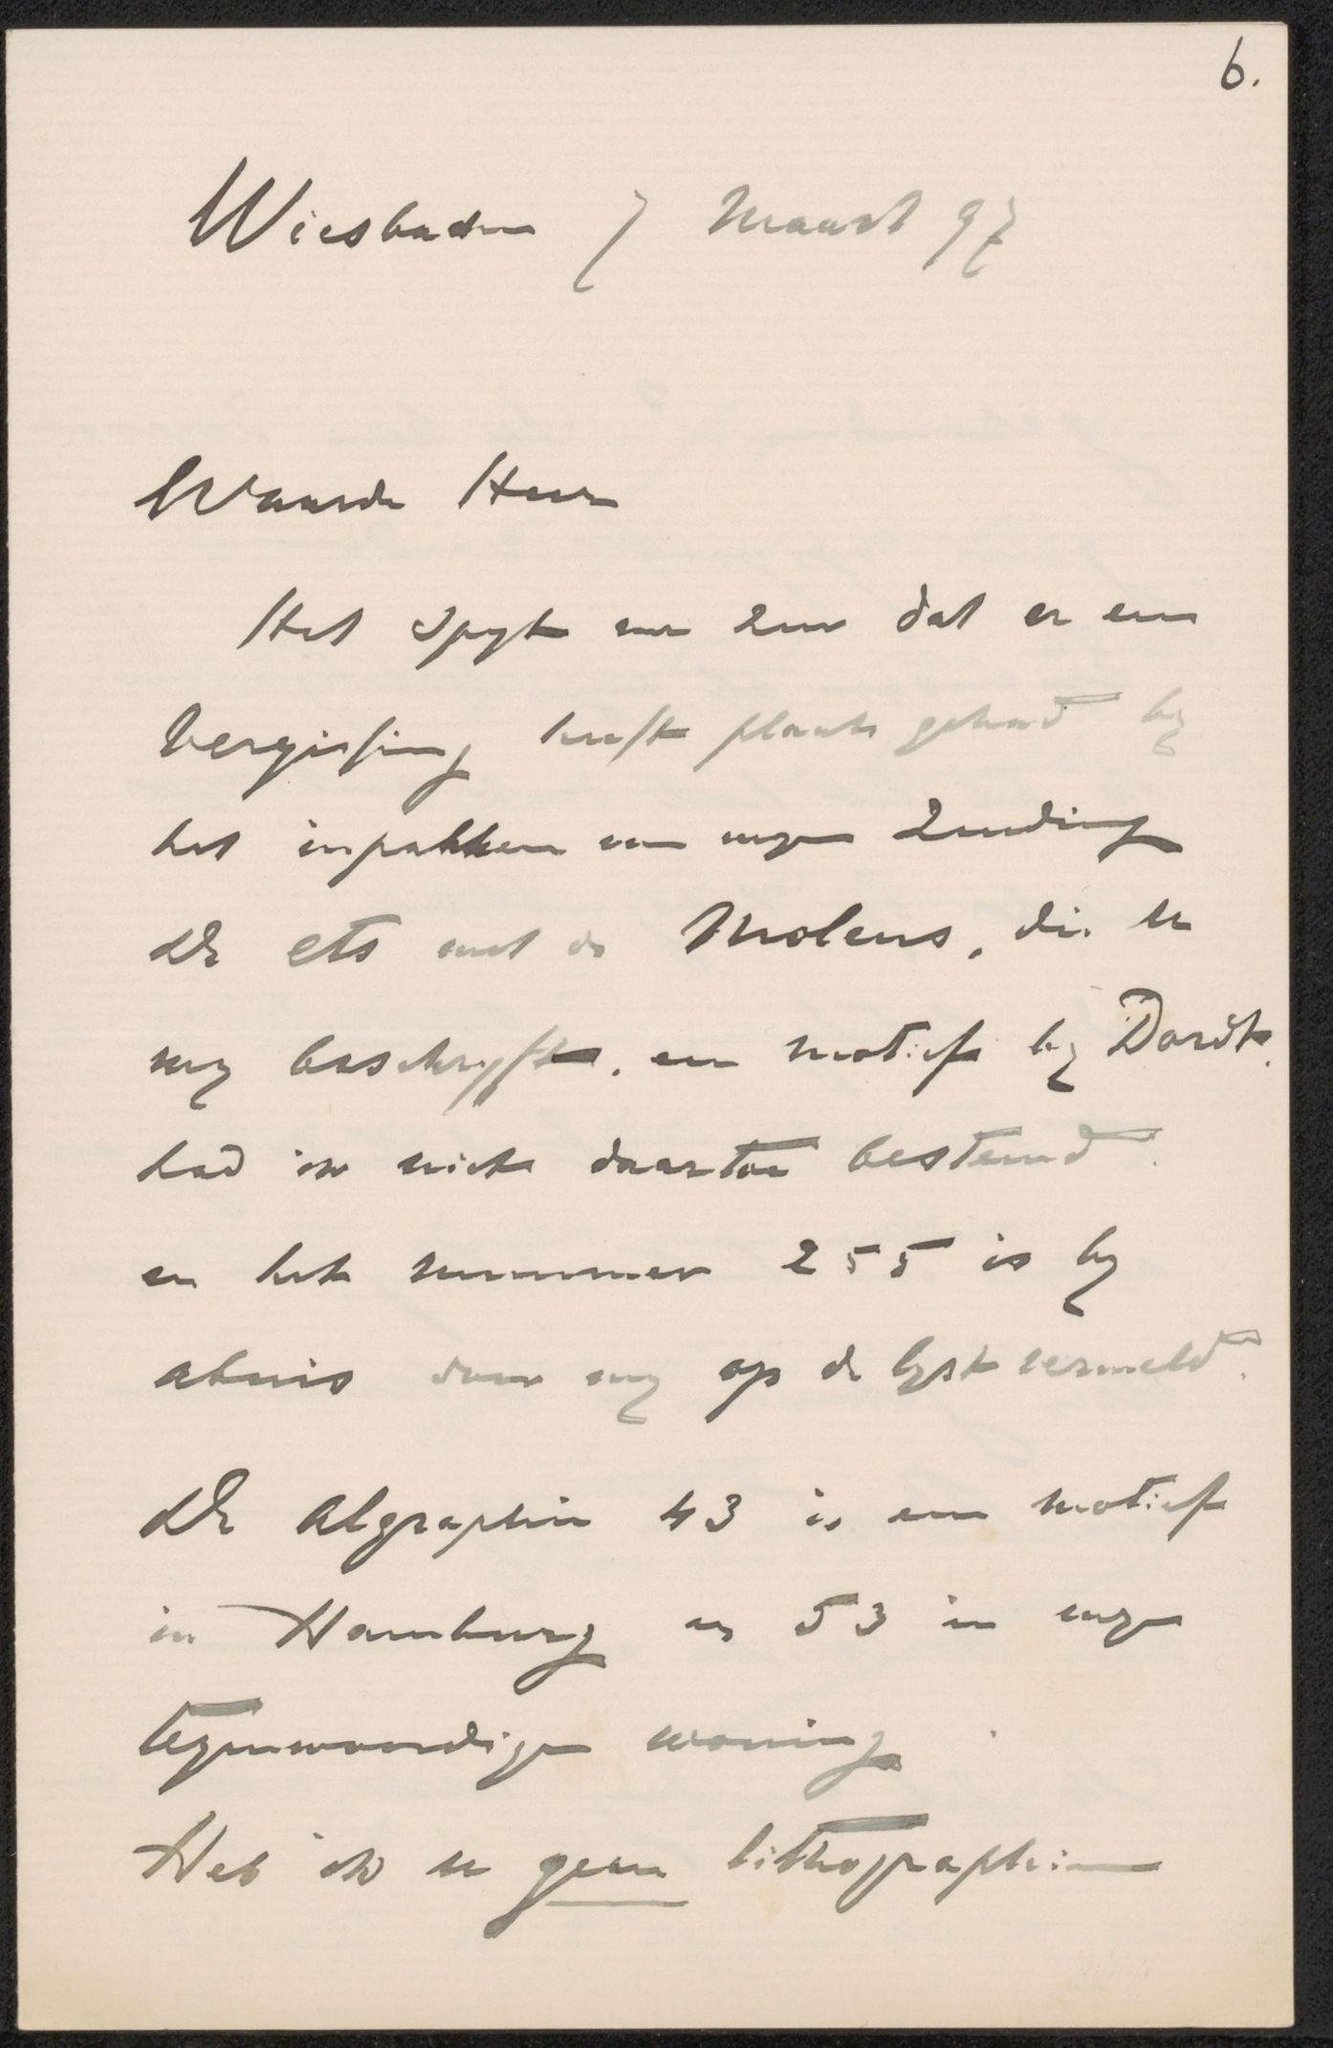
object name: letter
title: Brief aan Pieter Haverkorn van Rijsewijk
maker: carel nicolaas storm van s-gravesande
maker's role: draughtsman, print maker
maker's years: 1841-1924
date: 1897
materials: ink, paper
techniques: pen, writing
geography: wiesbaden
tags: museum, painter, johan barthold jongkind, pieter haverkorn van rijsewijk, the graphic arts, exhibition ~ art, money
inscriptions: collector's mark: ‘RPK’